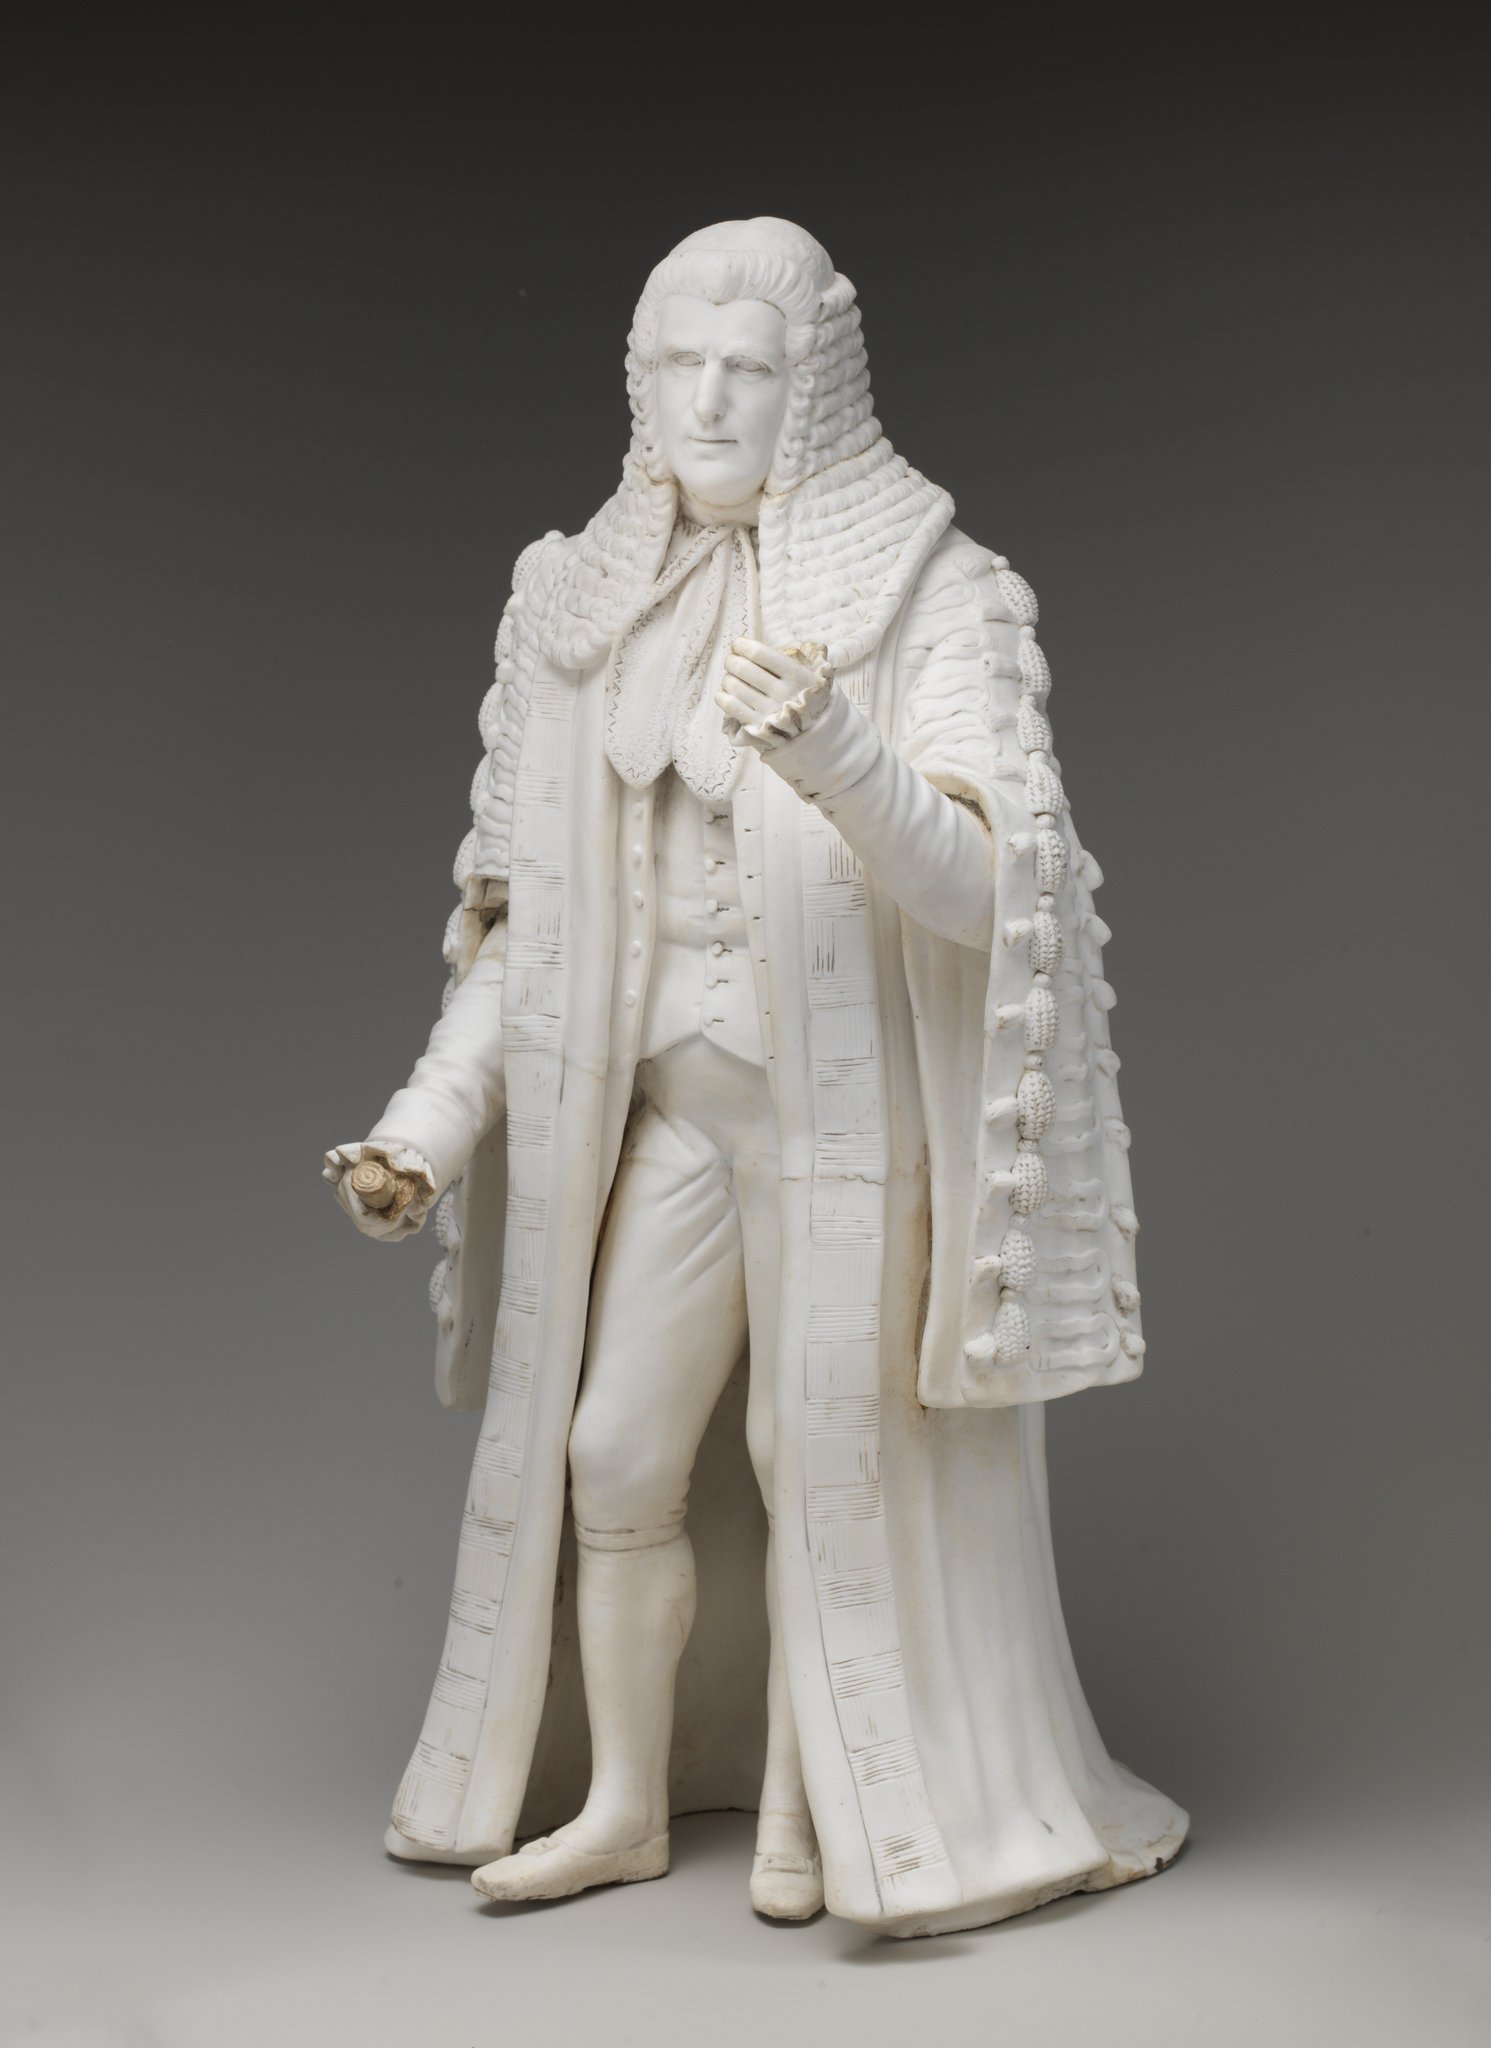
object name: figure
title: Lord Lyndhurst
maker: samuel alcock & co.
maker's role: factory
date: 1829-1830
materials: porcelain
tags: men